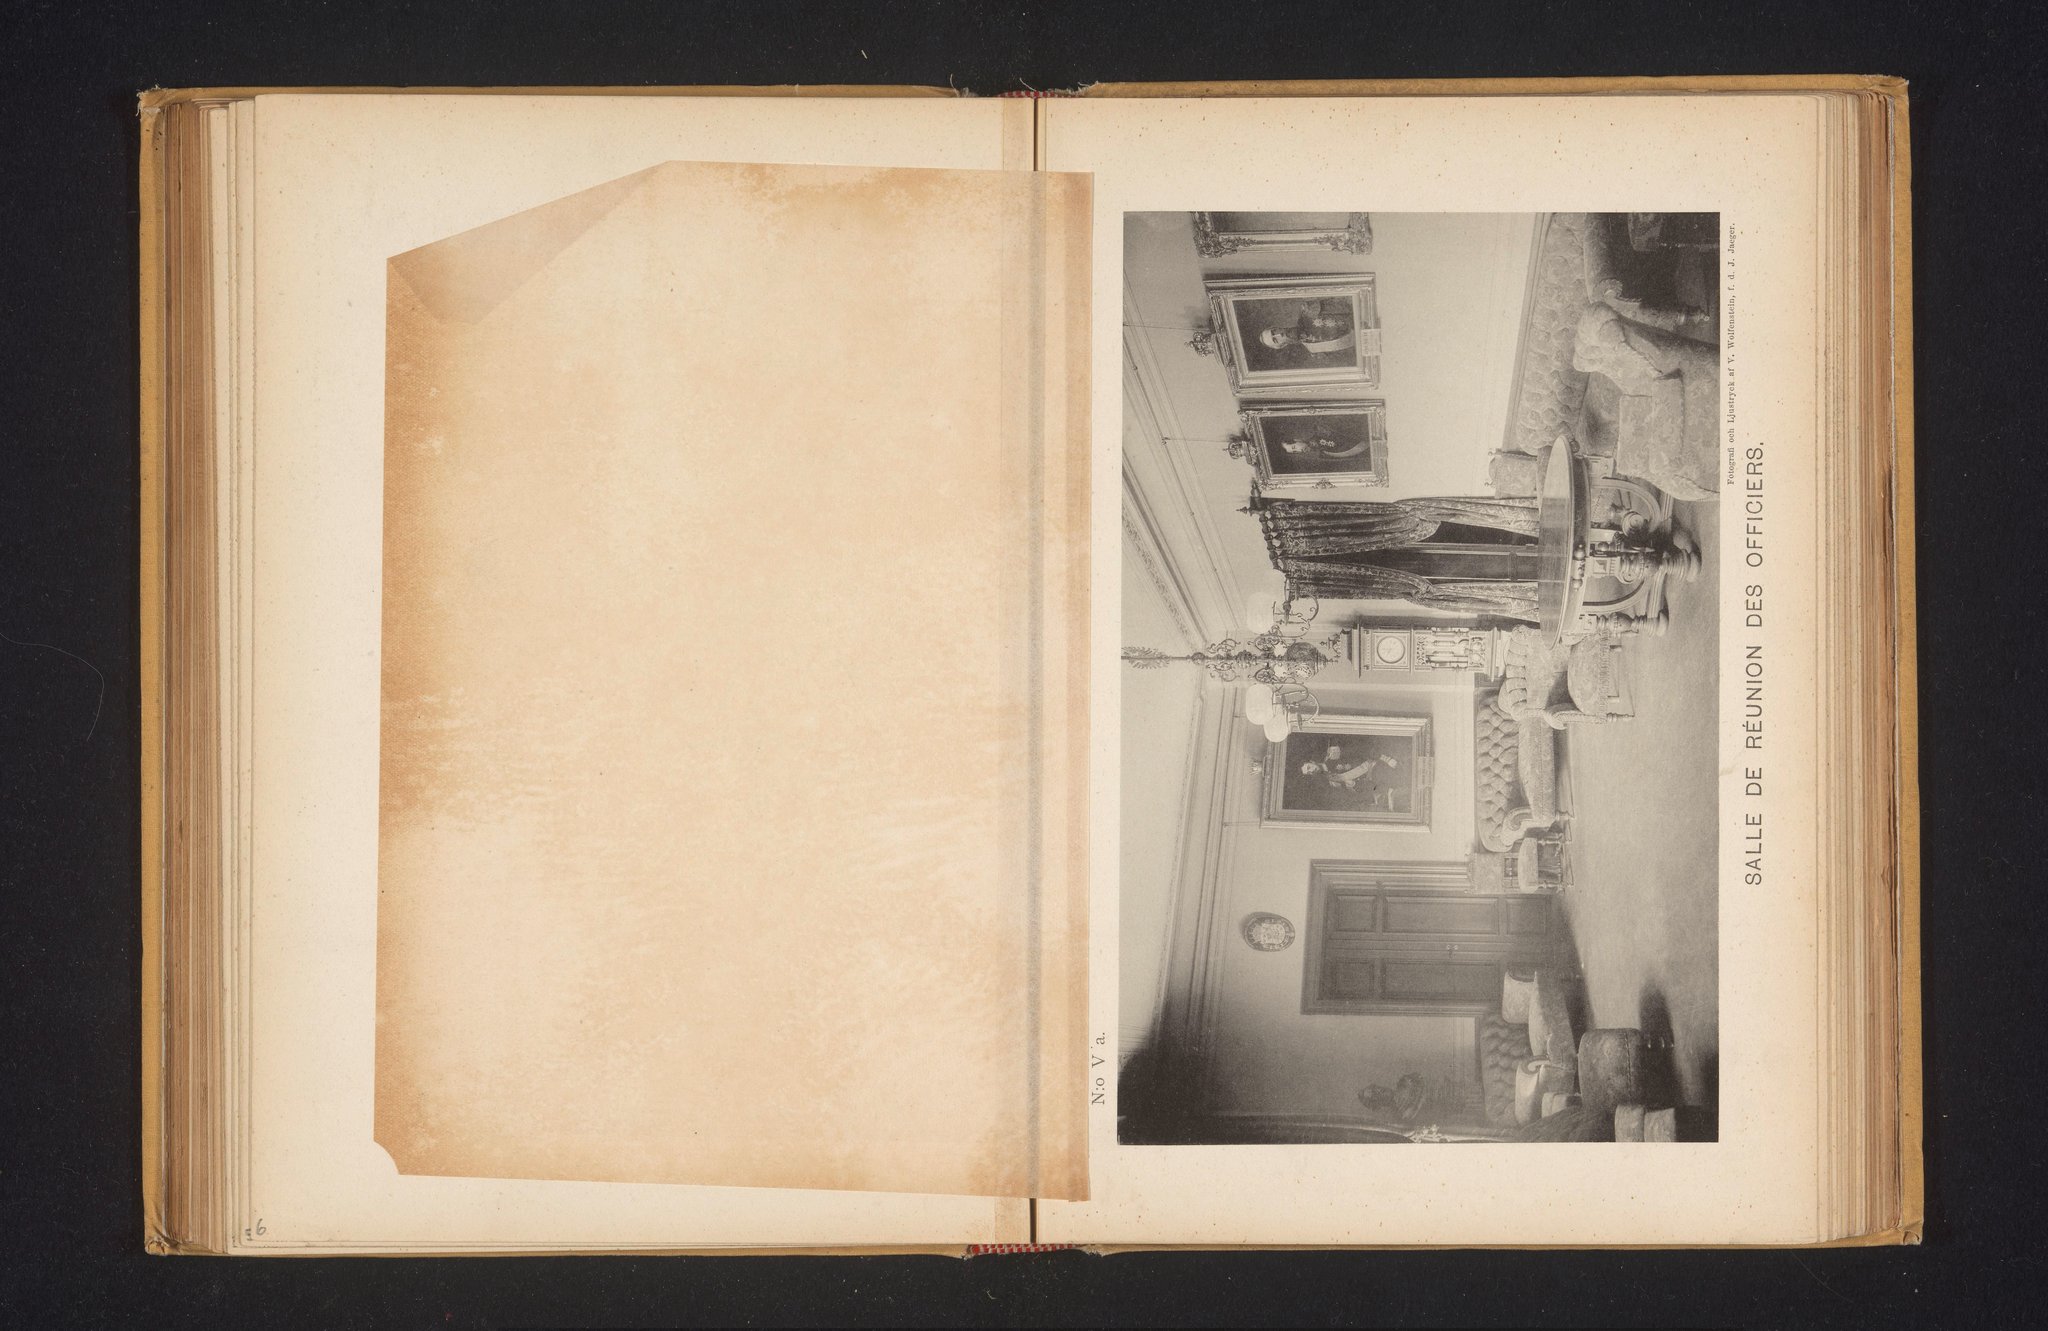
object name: photomechanical print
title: Salle de réunion des officiers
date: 1888-1891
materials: paper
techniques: photograph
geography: stockholm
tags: vestibule, hall, picture, painting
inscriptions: number: ‘N:o V a.’